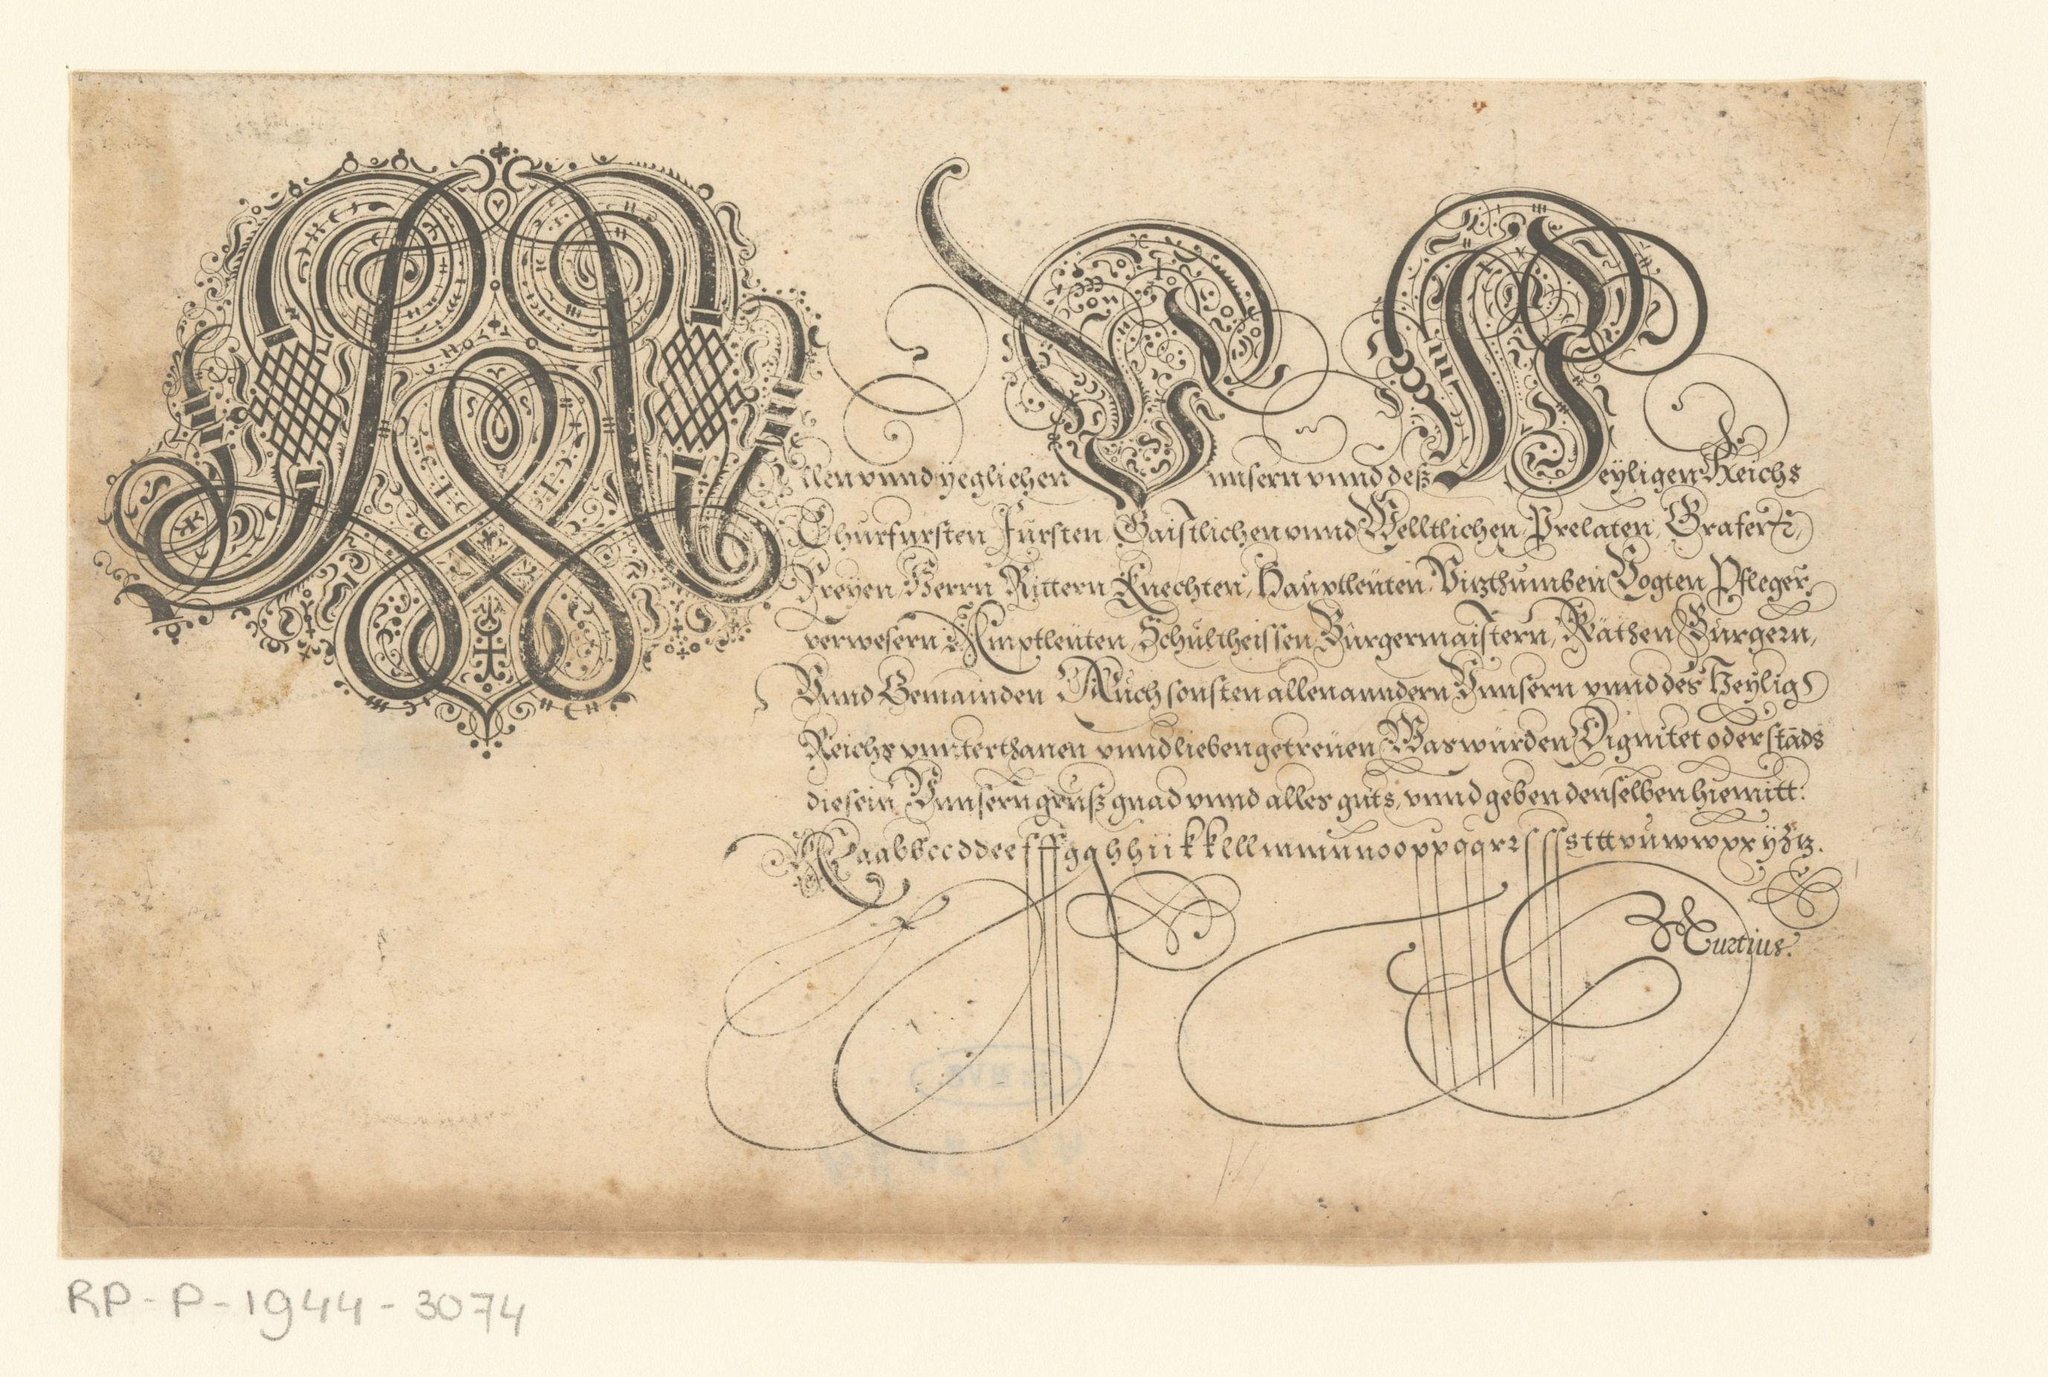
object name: print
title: Schrijfvoorbeeld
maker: curtius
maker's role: schrijver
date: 1600-1699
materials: paper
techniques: engraving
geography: germany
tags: calligraphy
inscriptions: collector's mark: Lugt 2228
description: Gekalligrafeerde Duitse tekst. Daaronder het alfabet.